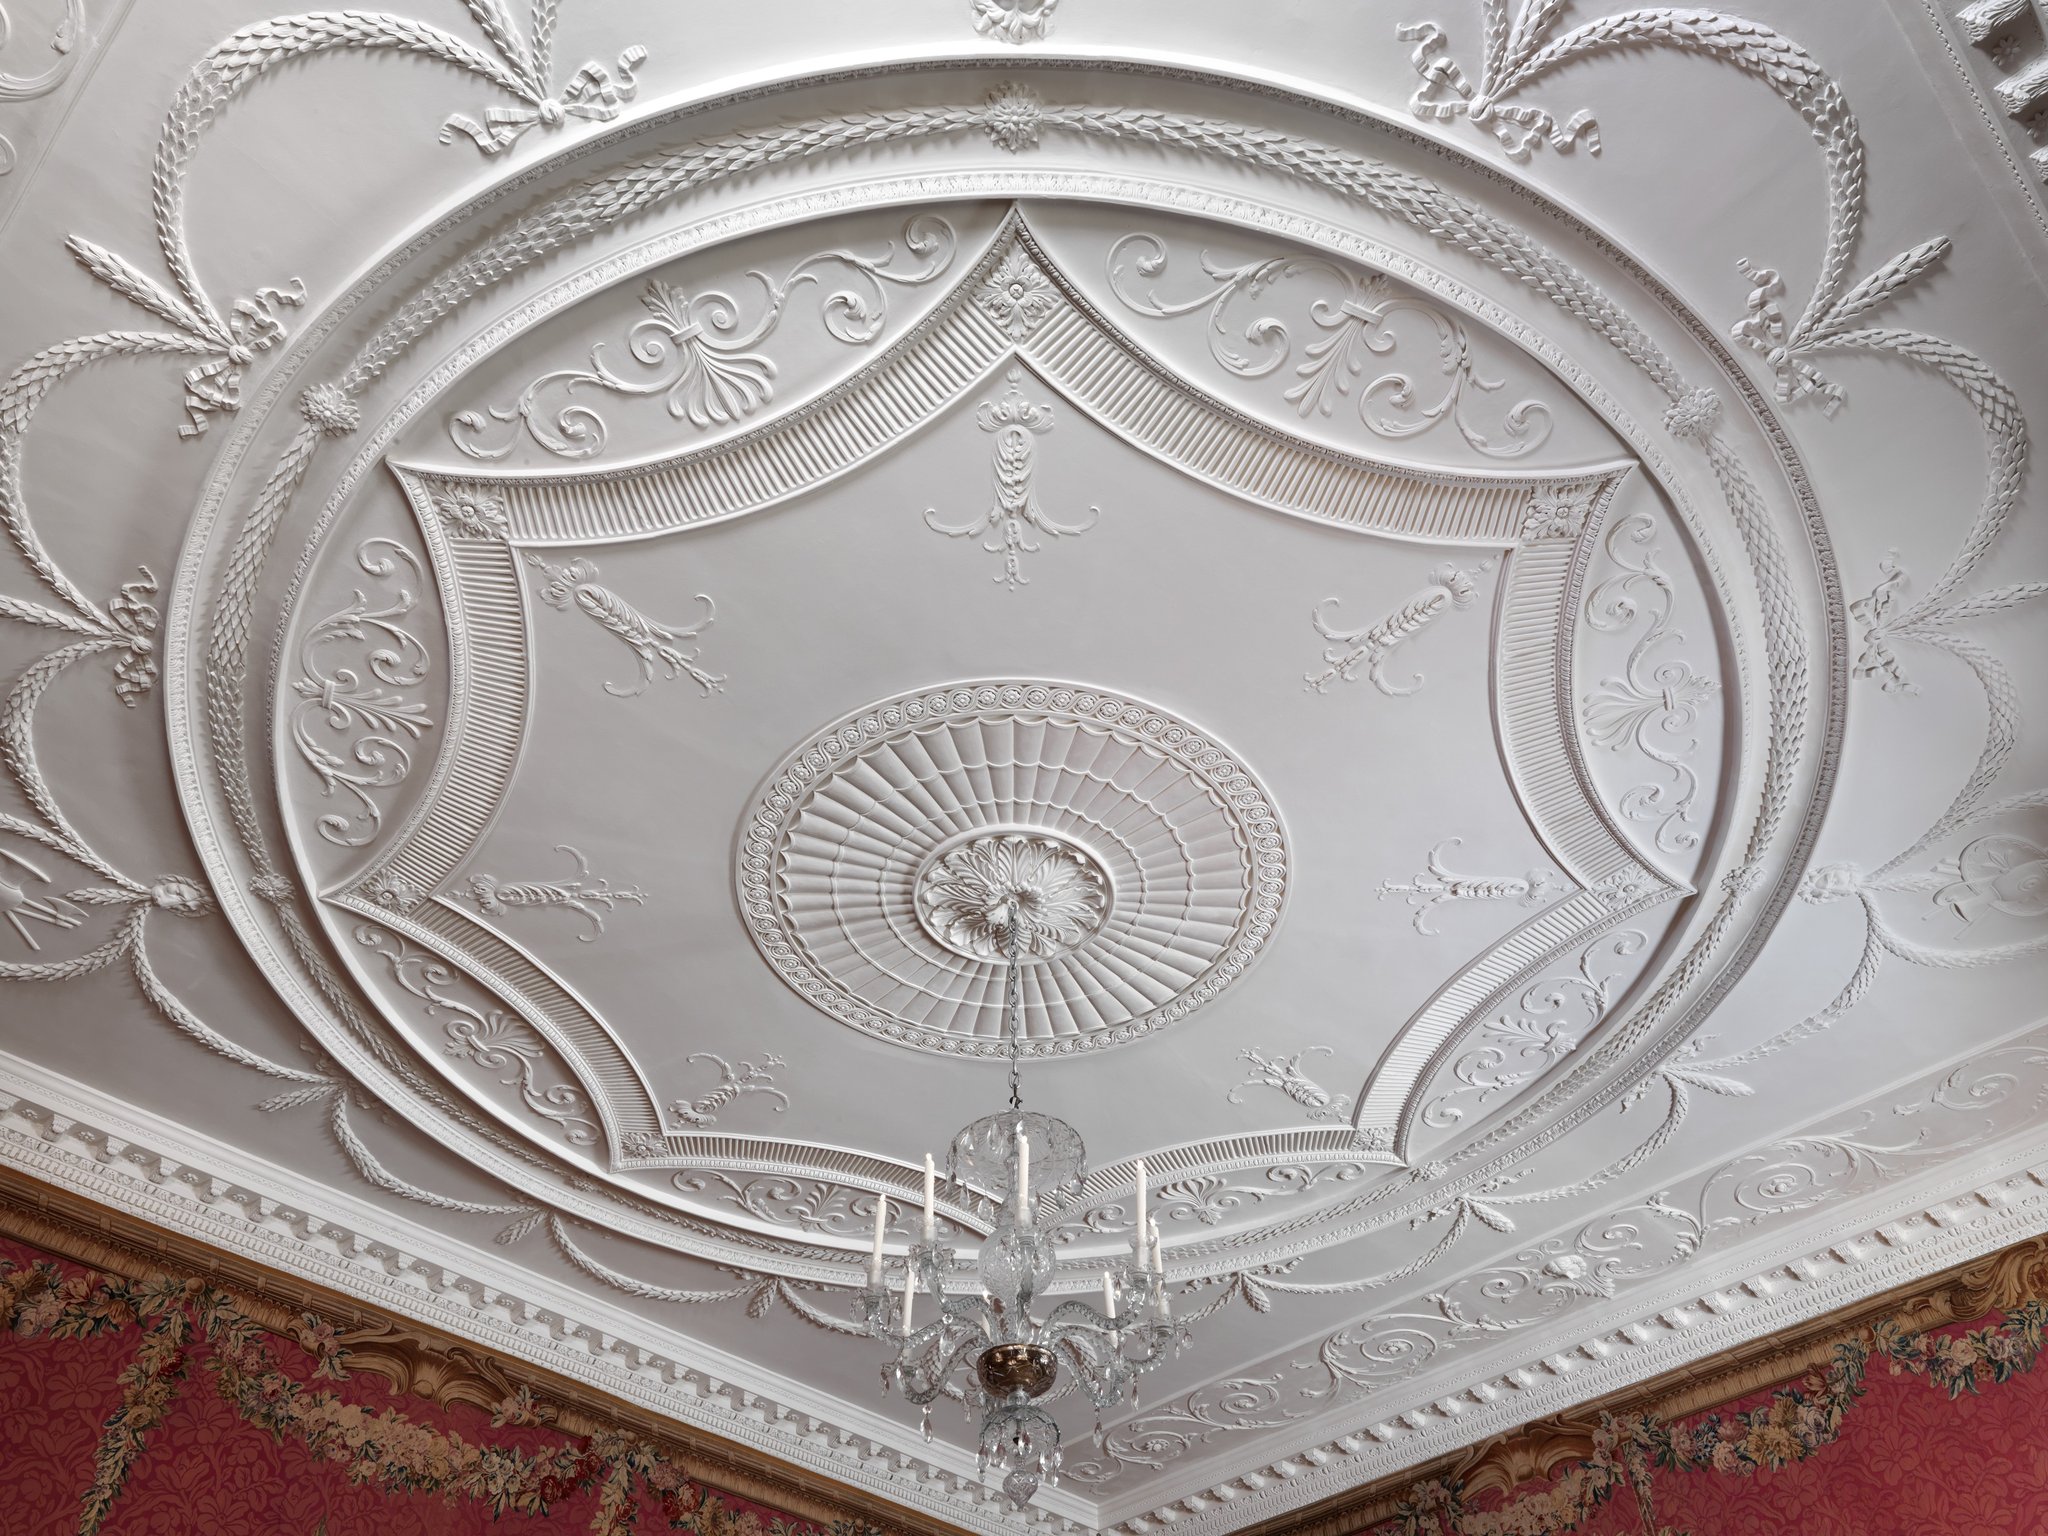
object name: period room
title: Woodwork and ceiling from the Tapestry Room from Croome Court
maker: robert adam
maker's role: designer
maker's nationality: british, scottish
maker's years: 1728-1792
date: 1760-1769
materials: plaster, wood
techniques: tapestry